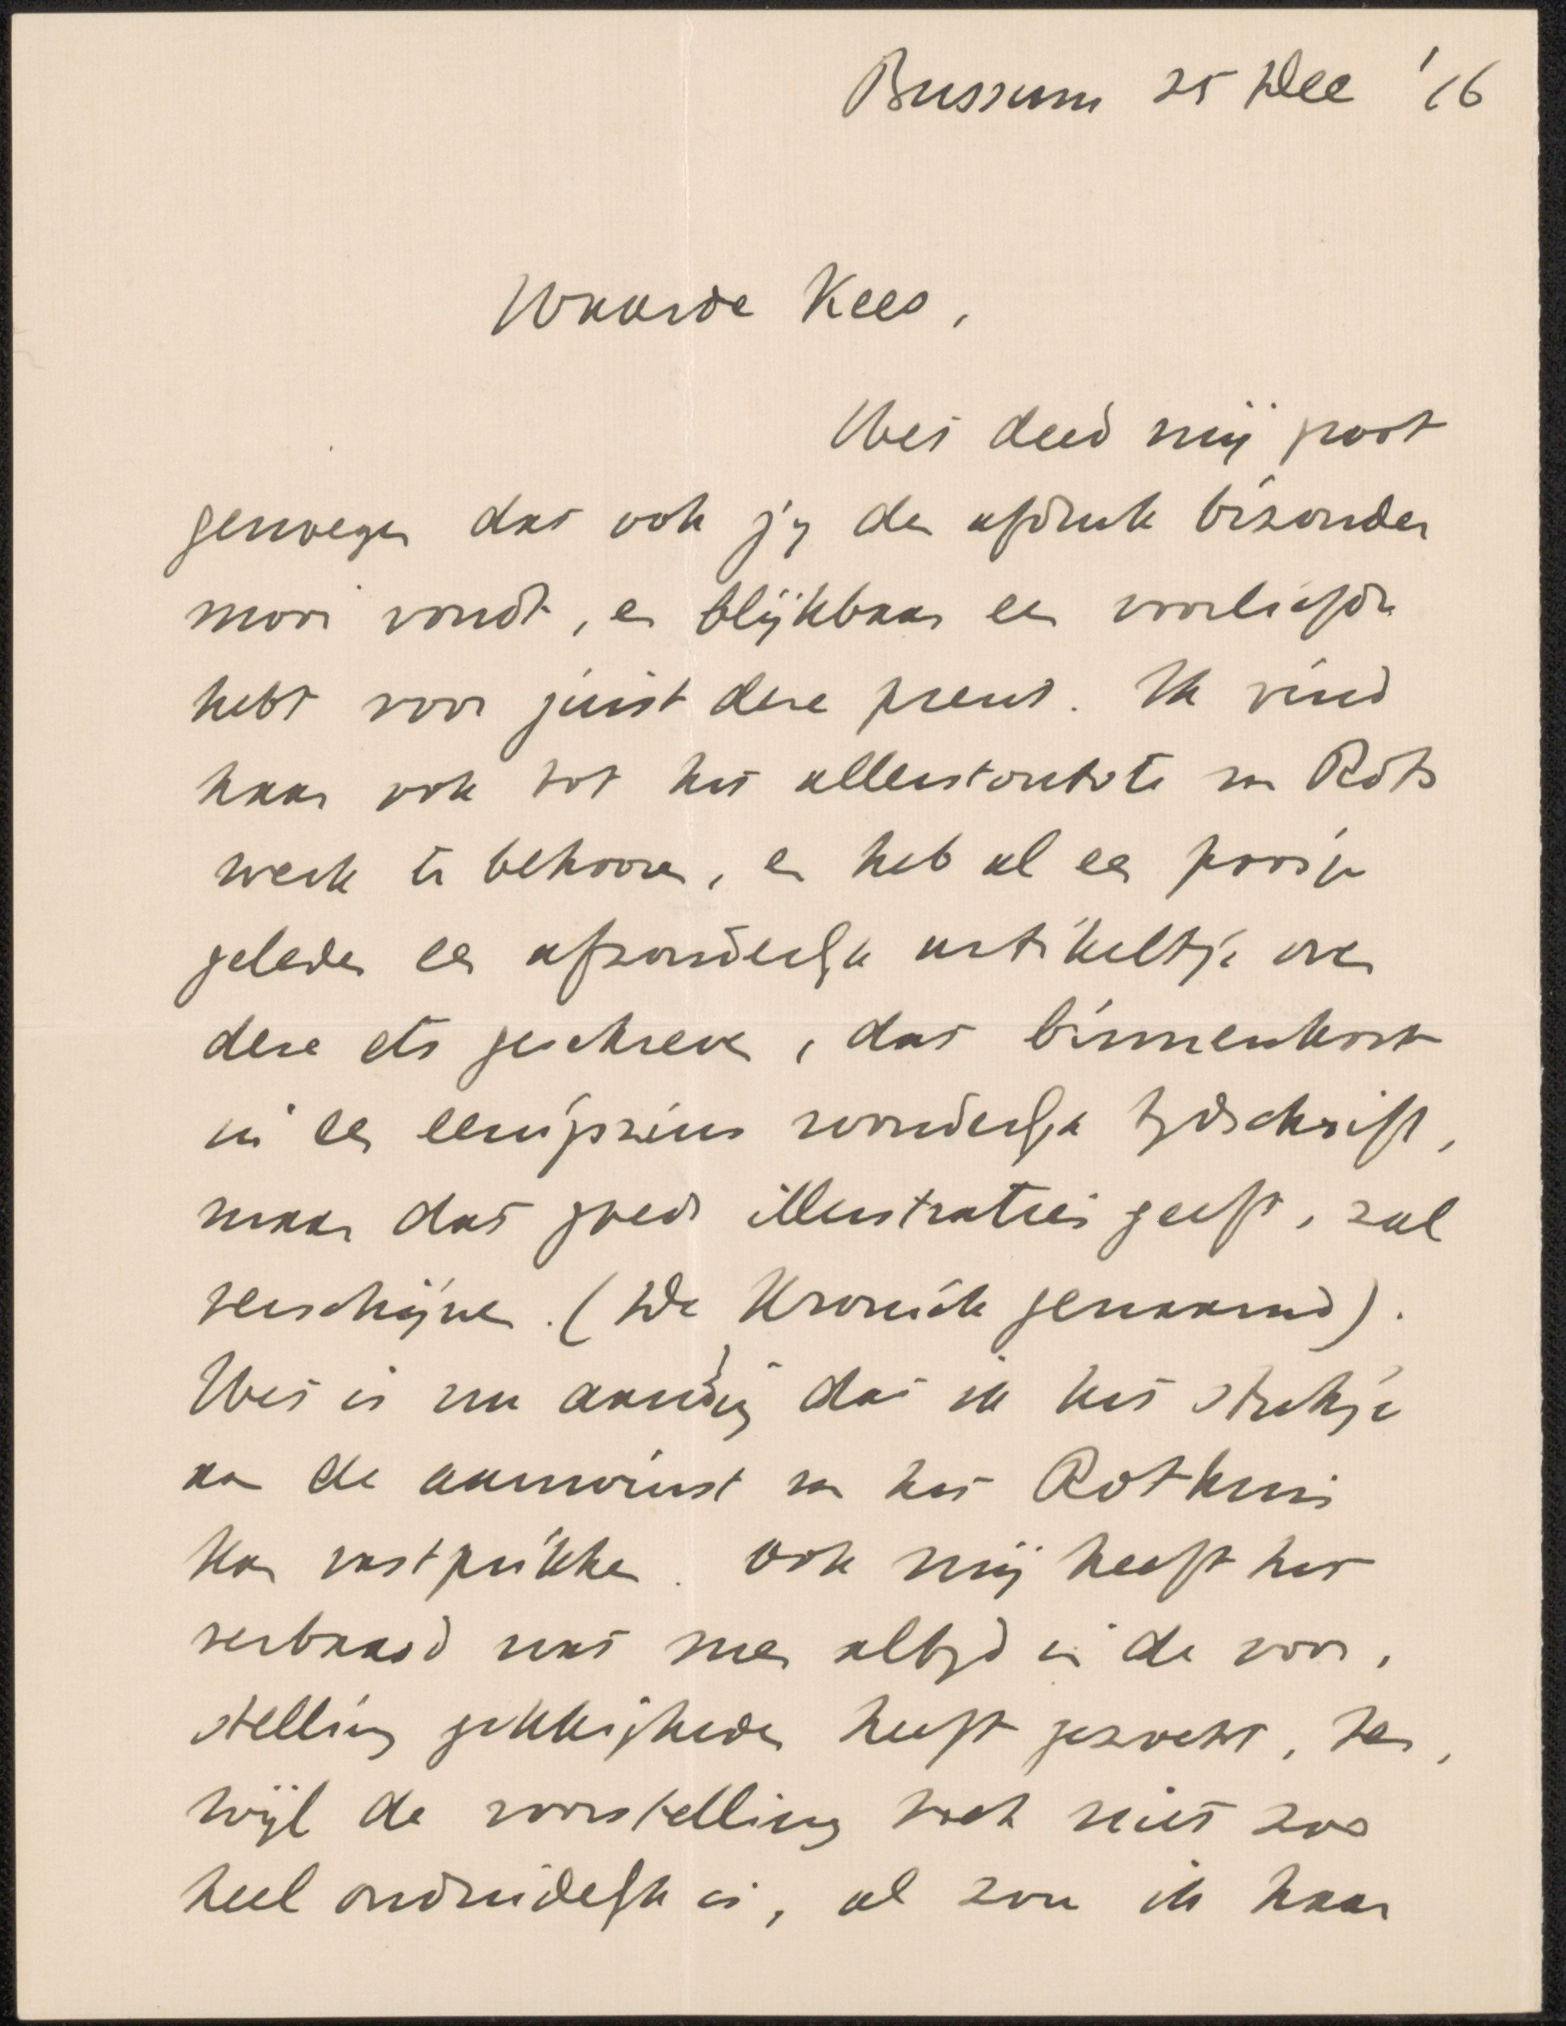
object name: letter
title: Brief aan Cornelis Gerardus 't Hooft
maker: jan veth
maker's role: designer, draughtsman, painter, print maker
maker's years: 1864-1925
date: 1916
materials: ink, paper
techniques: pen, writing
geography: bussum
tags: leiden, amsterdam, painter, print maker, draughtsman, rembrandt van rijn, cornelis gerardus 't hooft, the graphic arts, art collecting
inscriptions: collector's mark: ‘RPK’